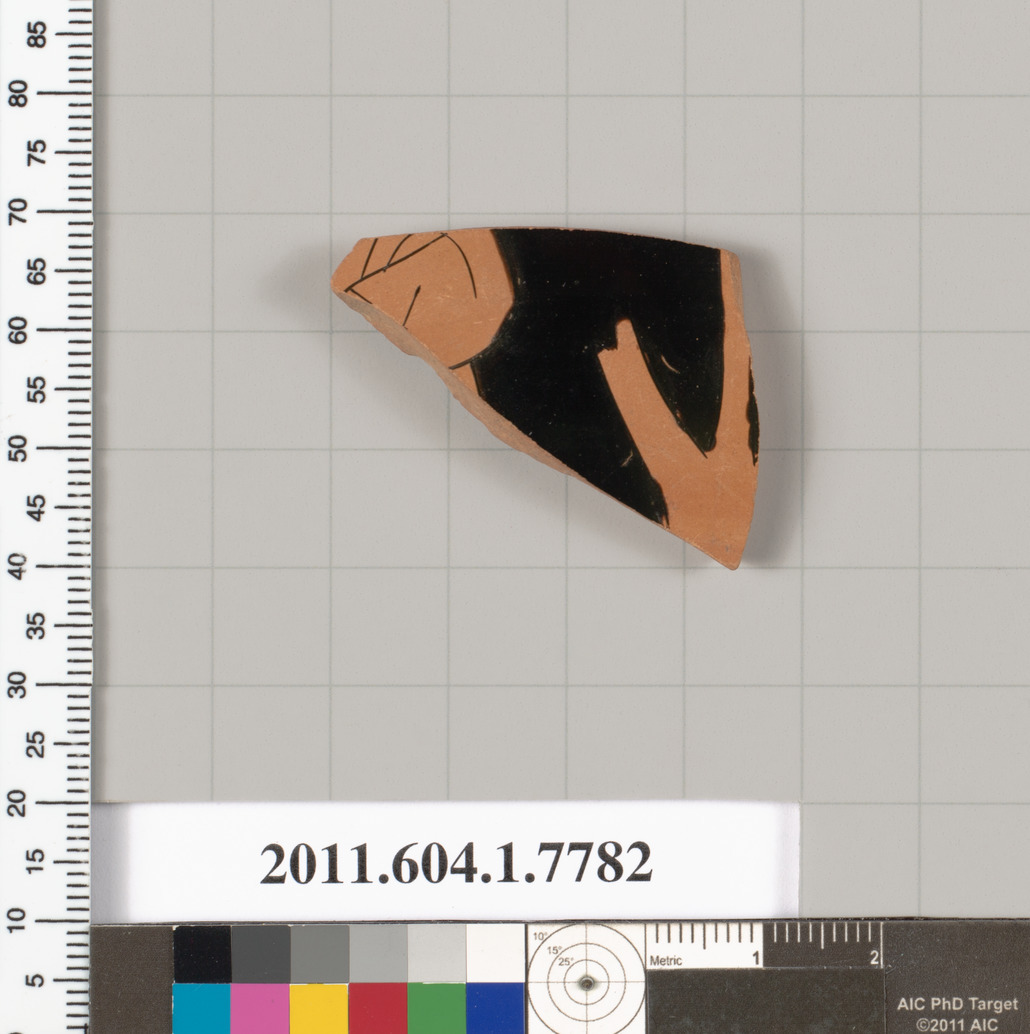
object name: kylix fragment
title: Terracotta fragment of a kylix (drinking cup)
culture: greek, attic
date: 460-450 BCE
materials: terracotta